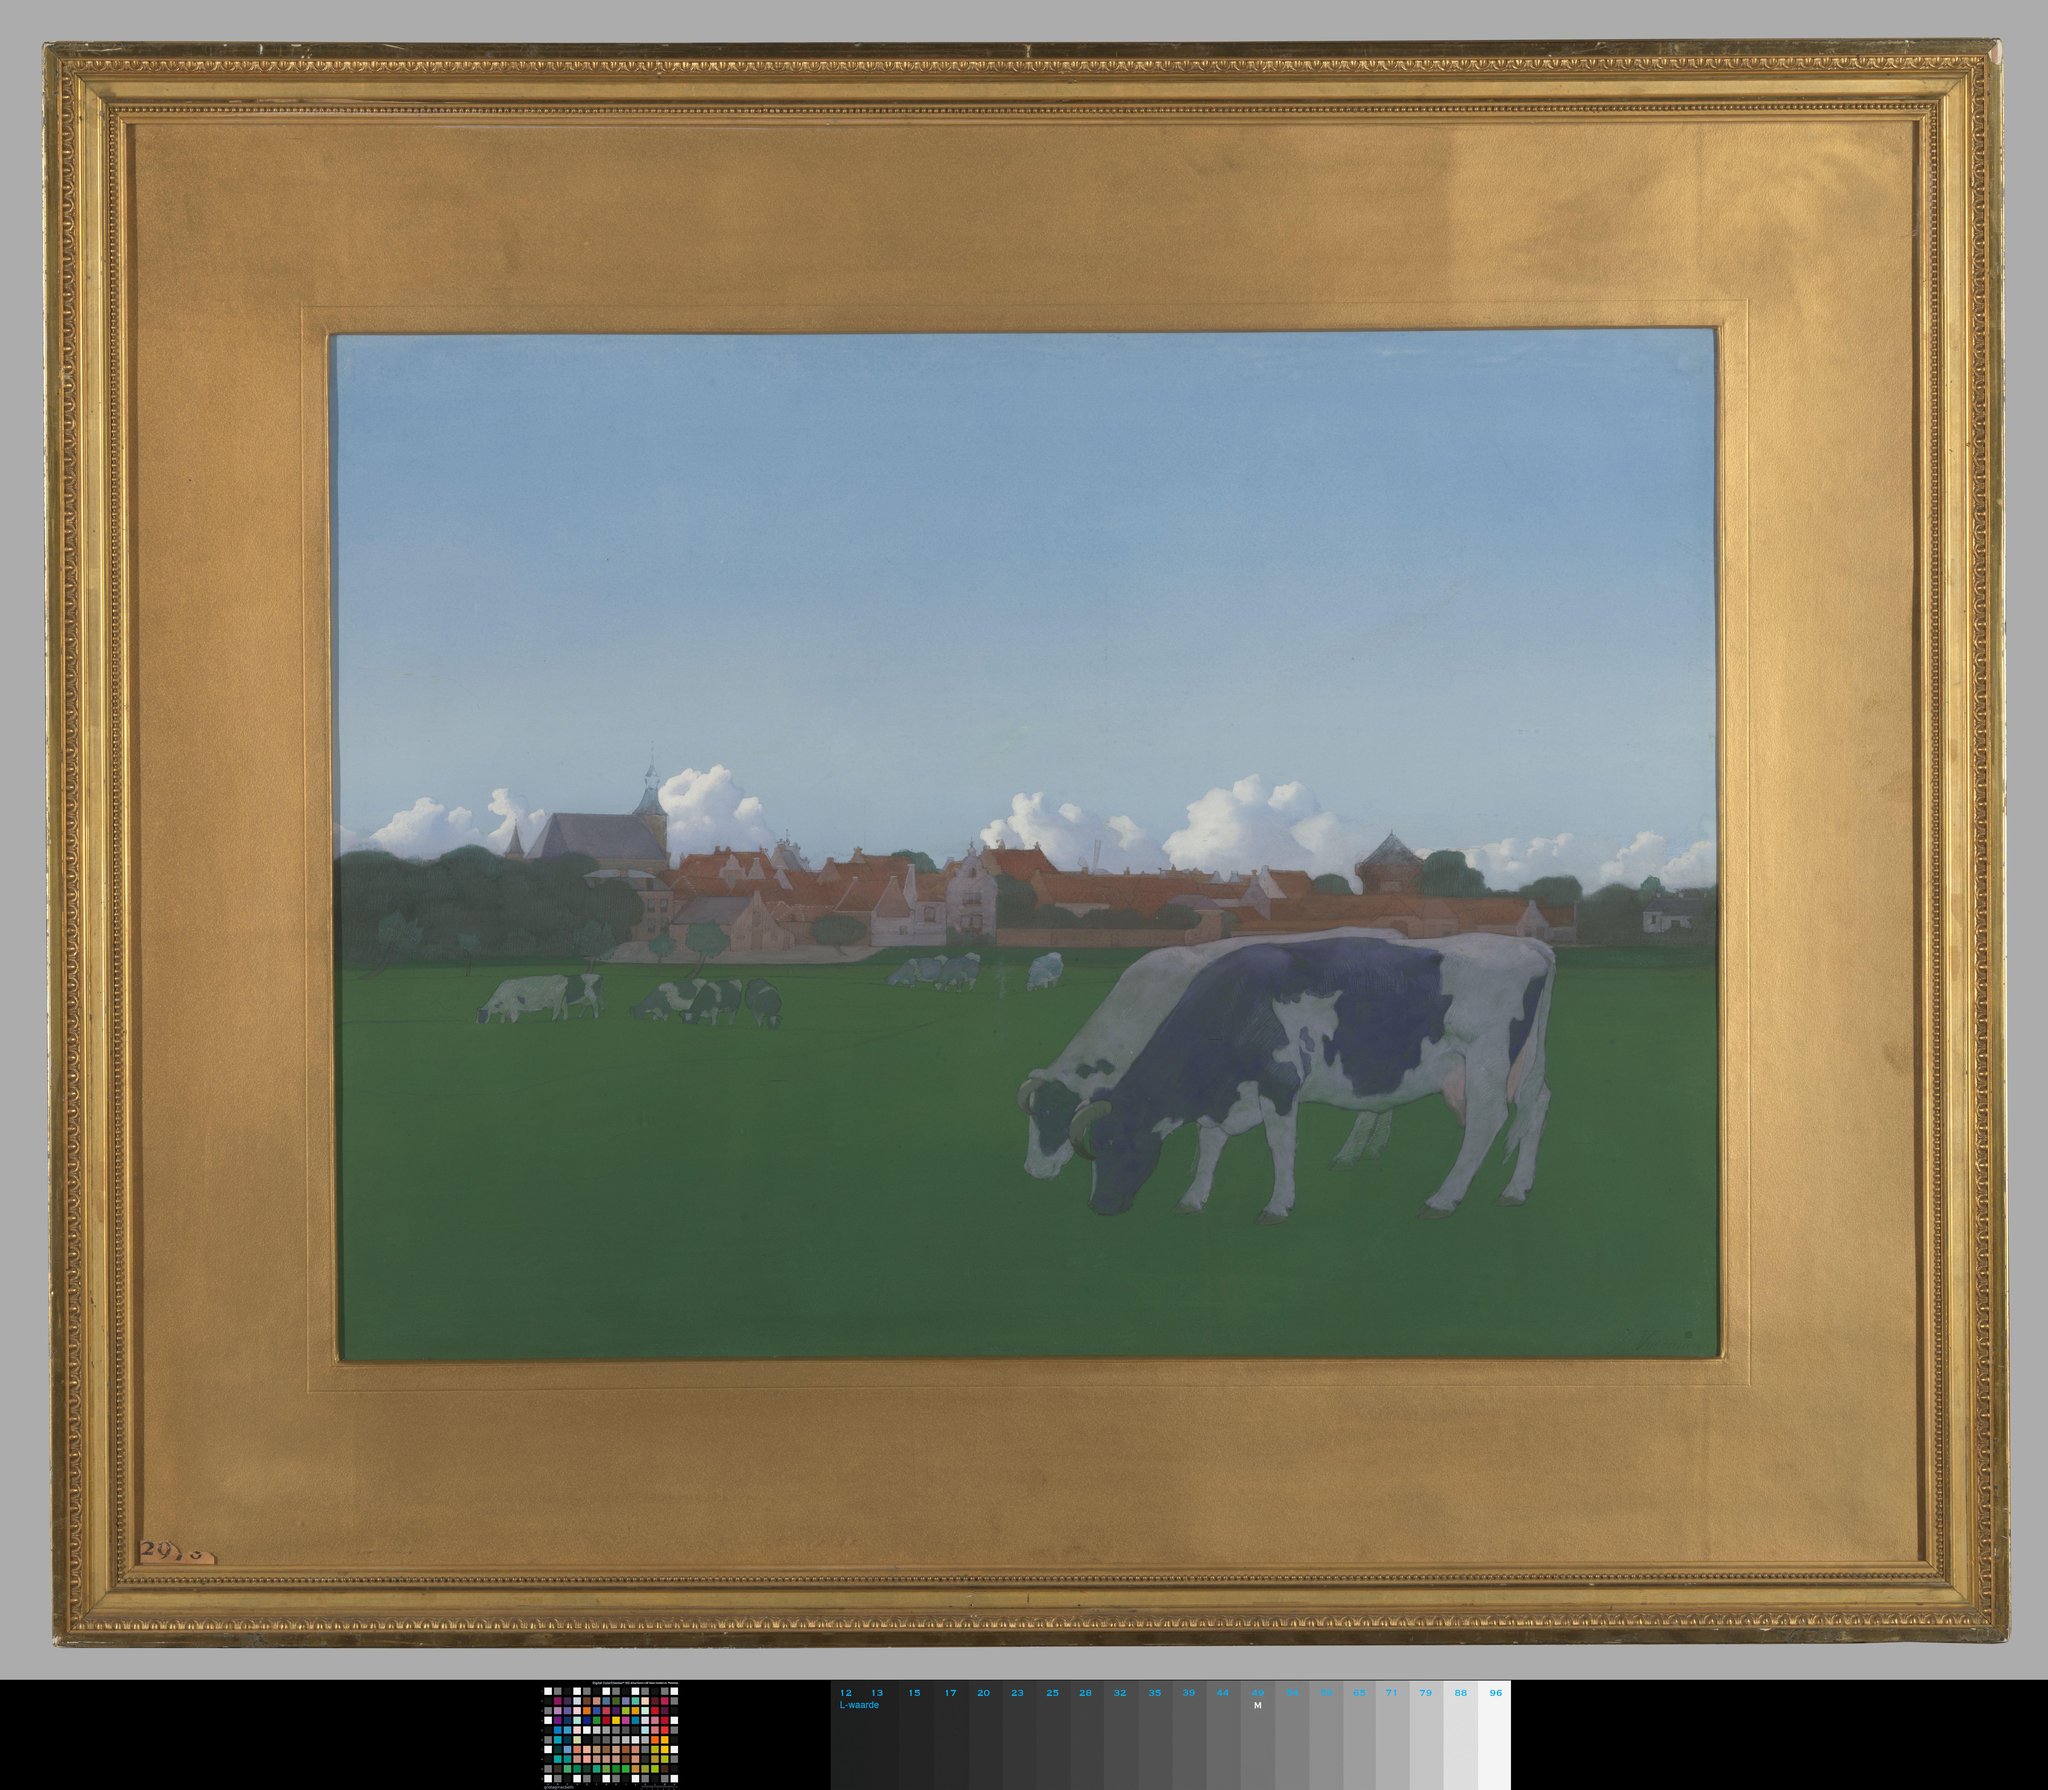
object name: drawing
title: Gezicht op Hattem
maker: jan voerman (1857-1941)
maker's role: draughtsman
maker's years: 1857-1941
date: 1867-1941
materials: paper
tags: cow, meadow, pasture